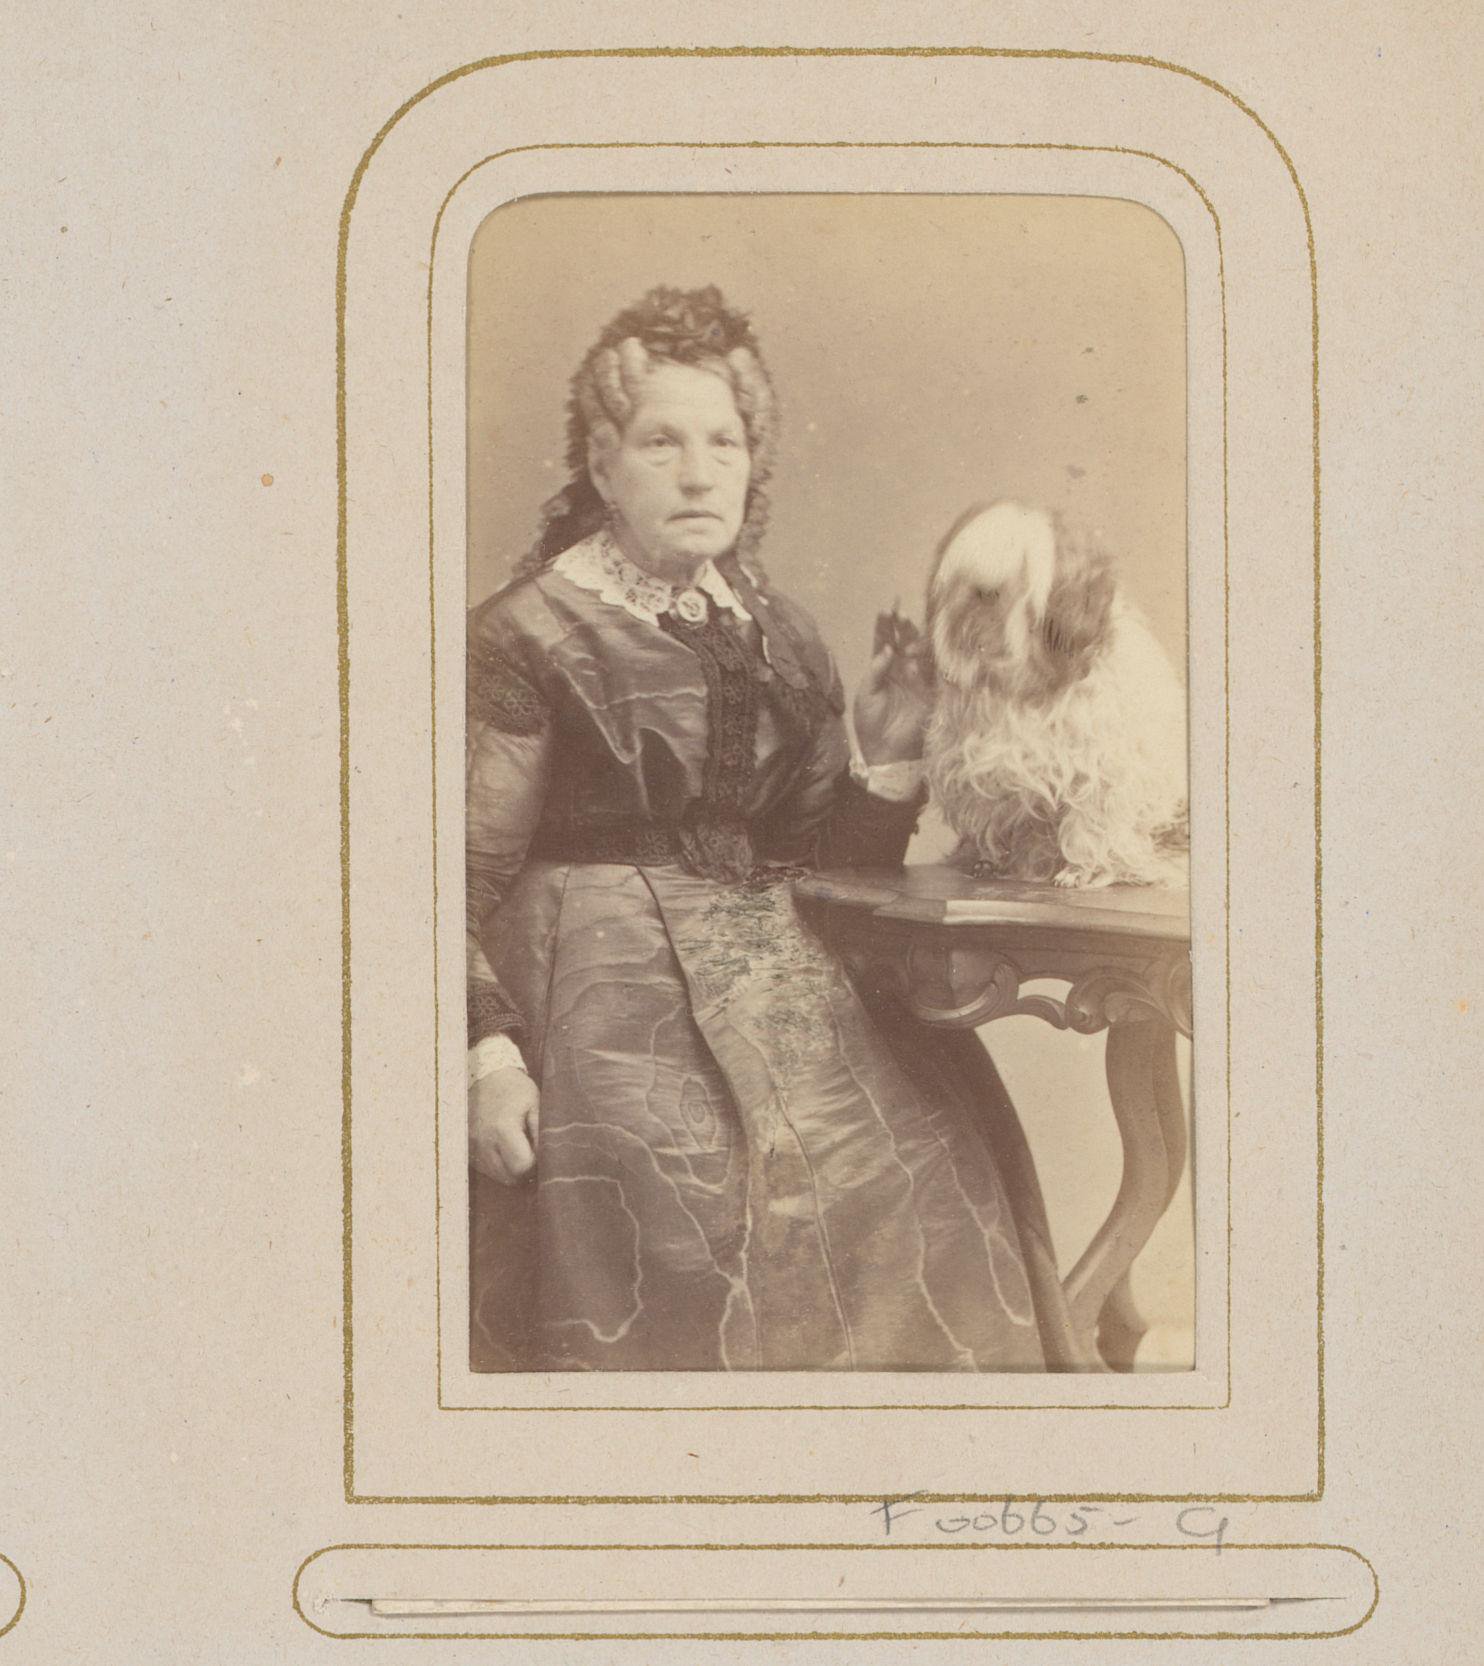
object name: photograph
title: Portret van een oude vrouw met hond op tafel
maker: Anonymous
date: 1860-1880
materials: cardboard, photographic support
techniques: albumen print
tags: historical persons - bb - woman, old woman